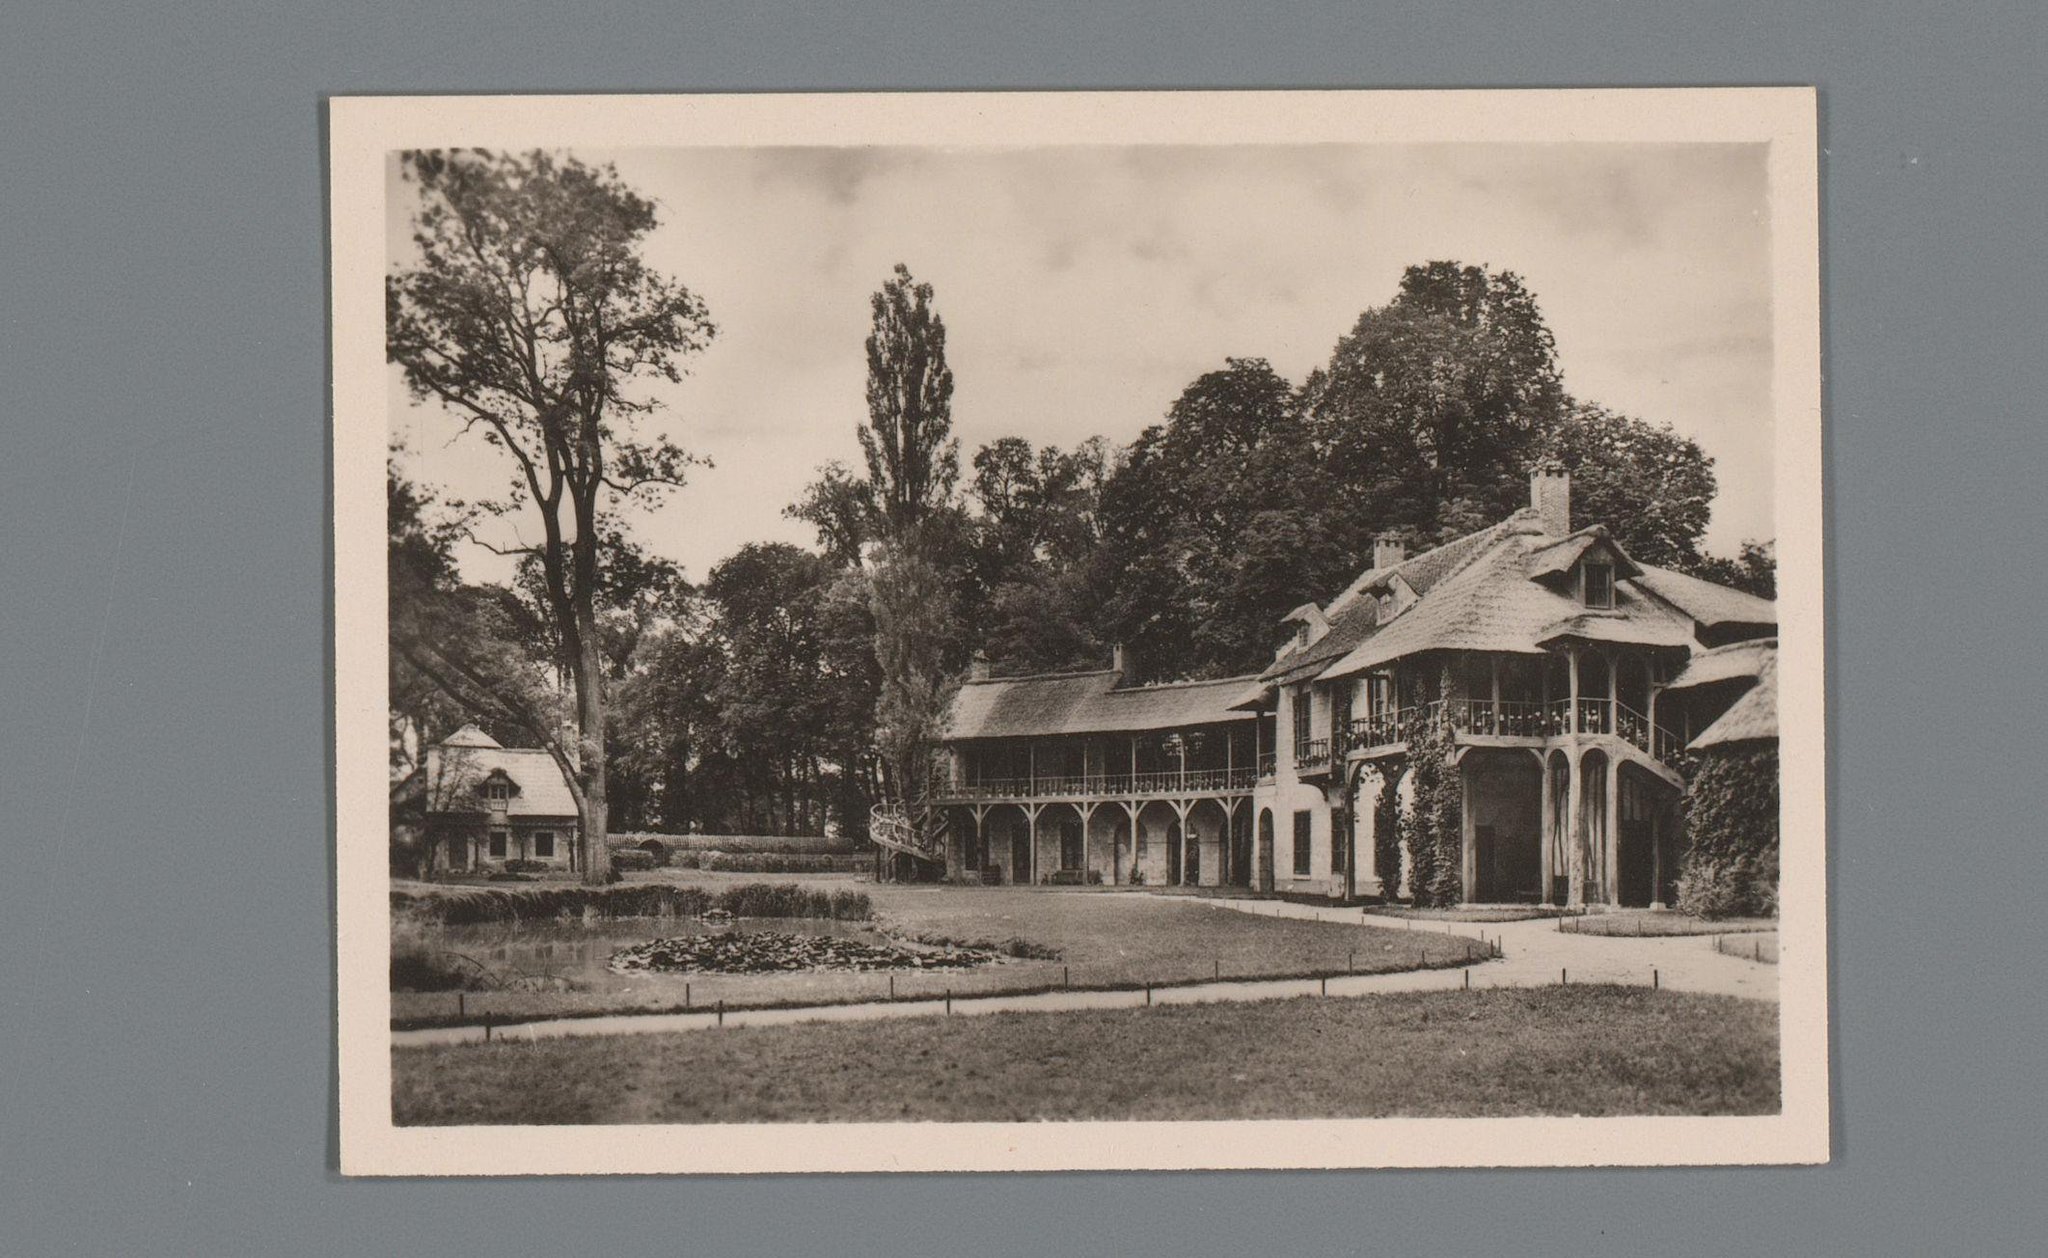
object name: photograph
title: Hameau de Trianon - Maison de la Reine / The Hamlet of Trianon - The Queen's House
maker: Anonymous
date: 1900-1920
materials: paper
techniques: gelatin silver print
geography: versailles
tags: farm (building)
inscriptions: number: ‘19’